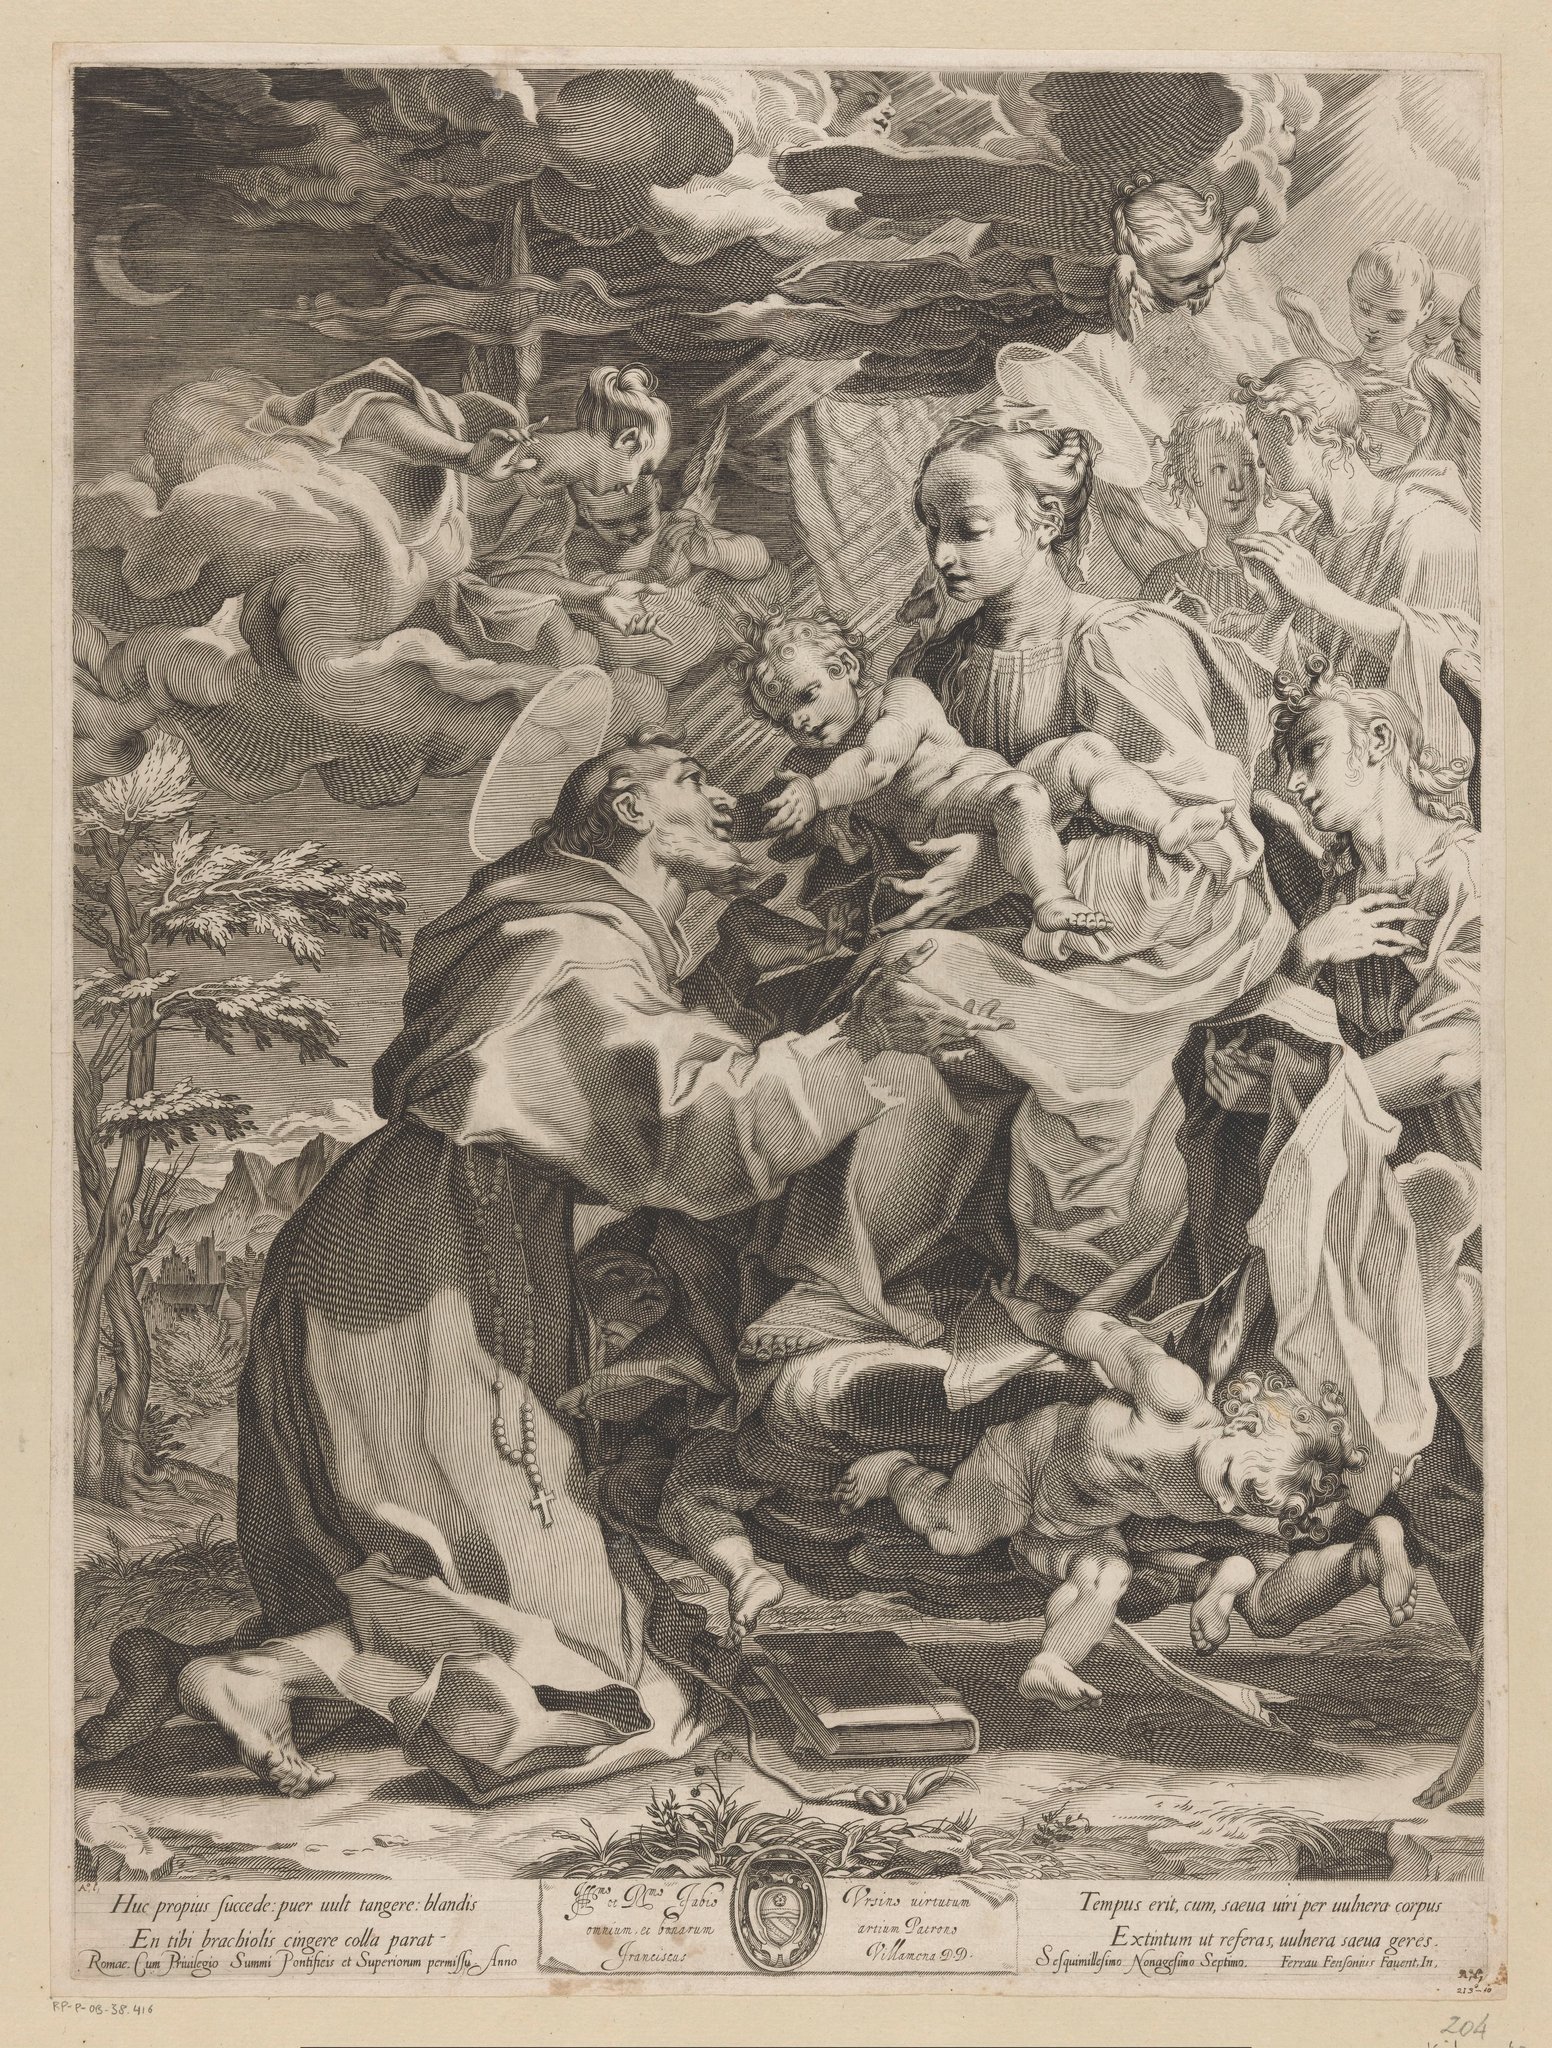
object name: print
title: Maria overhandigt het Christuskind aan Franciscus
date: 1597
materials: paper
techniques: engraving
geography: italy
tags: cherubs, i.e. children's heads with wings, angels, the virgin mary handing over the infant christ to st. francis of assisi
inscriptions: inscription: ‘Ao, L, Ao, L, 213o-10’, collector's mark: Lugt 240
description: Te midden van engelen overhandigt Maria het Christuskind aan de knielende heilige Franciscus van Assisi. Op de grond ligt een boek. Opdracht, wapenschild en Latijnse tekst in twee kolommen in ondermarge.